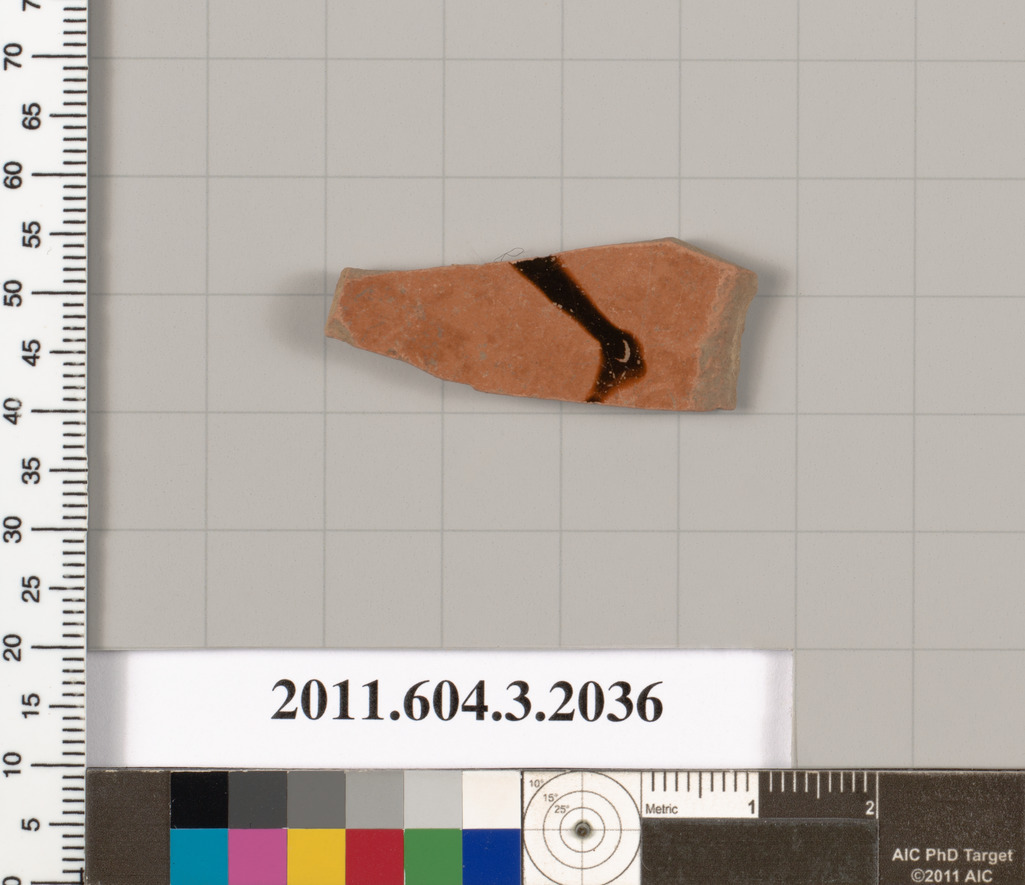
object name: kylix fragment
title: Terracotta fragment of a kylix (drinking cup)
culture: greek, attic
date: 500-468 BCE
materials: terracotta